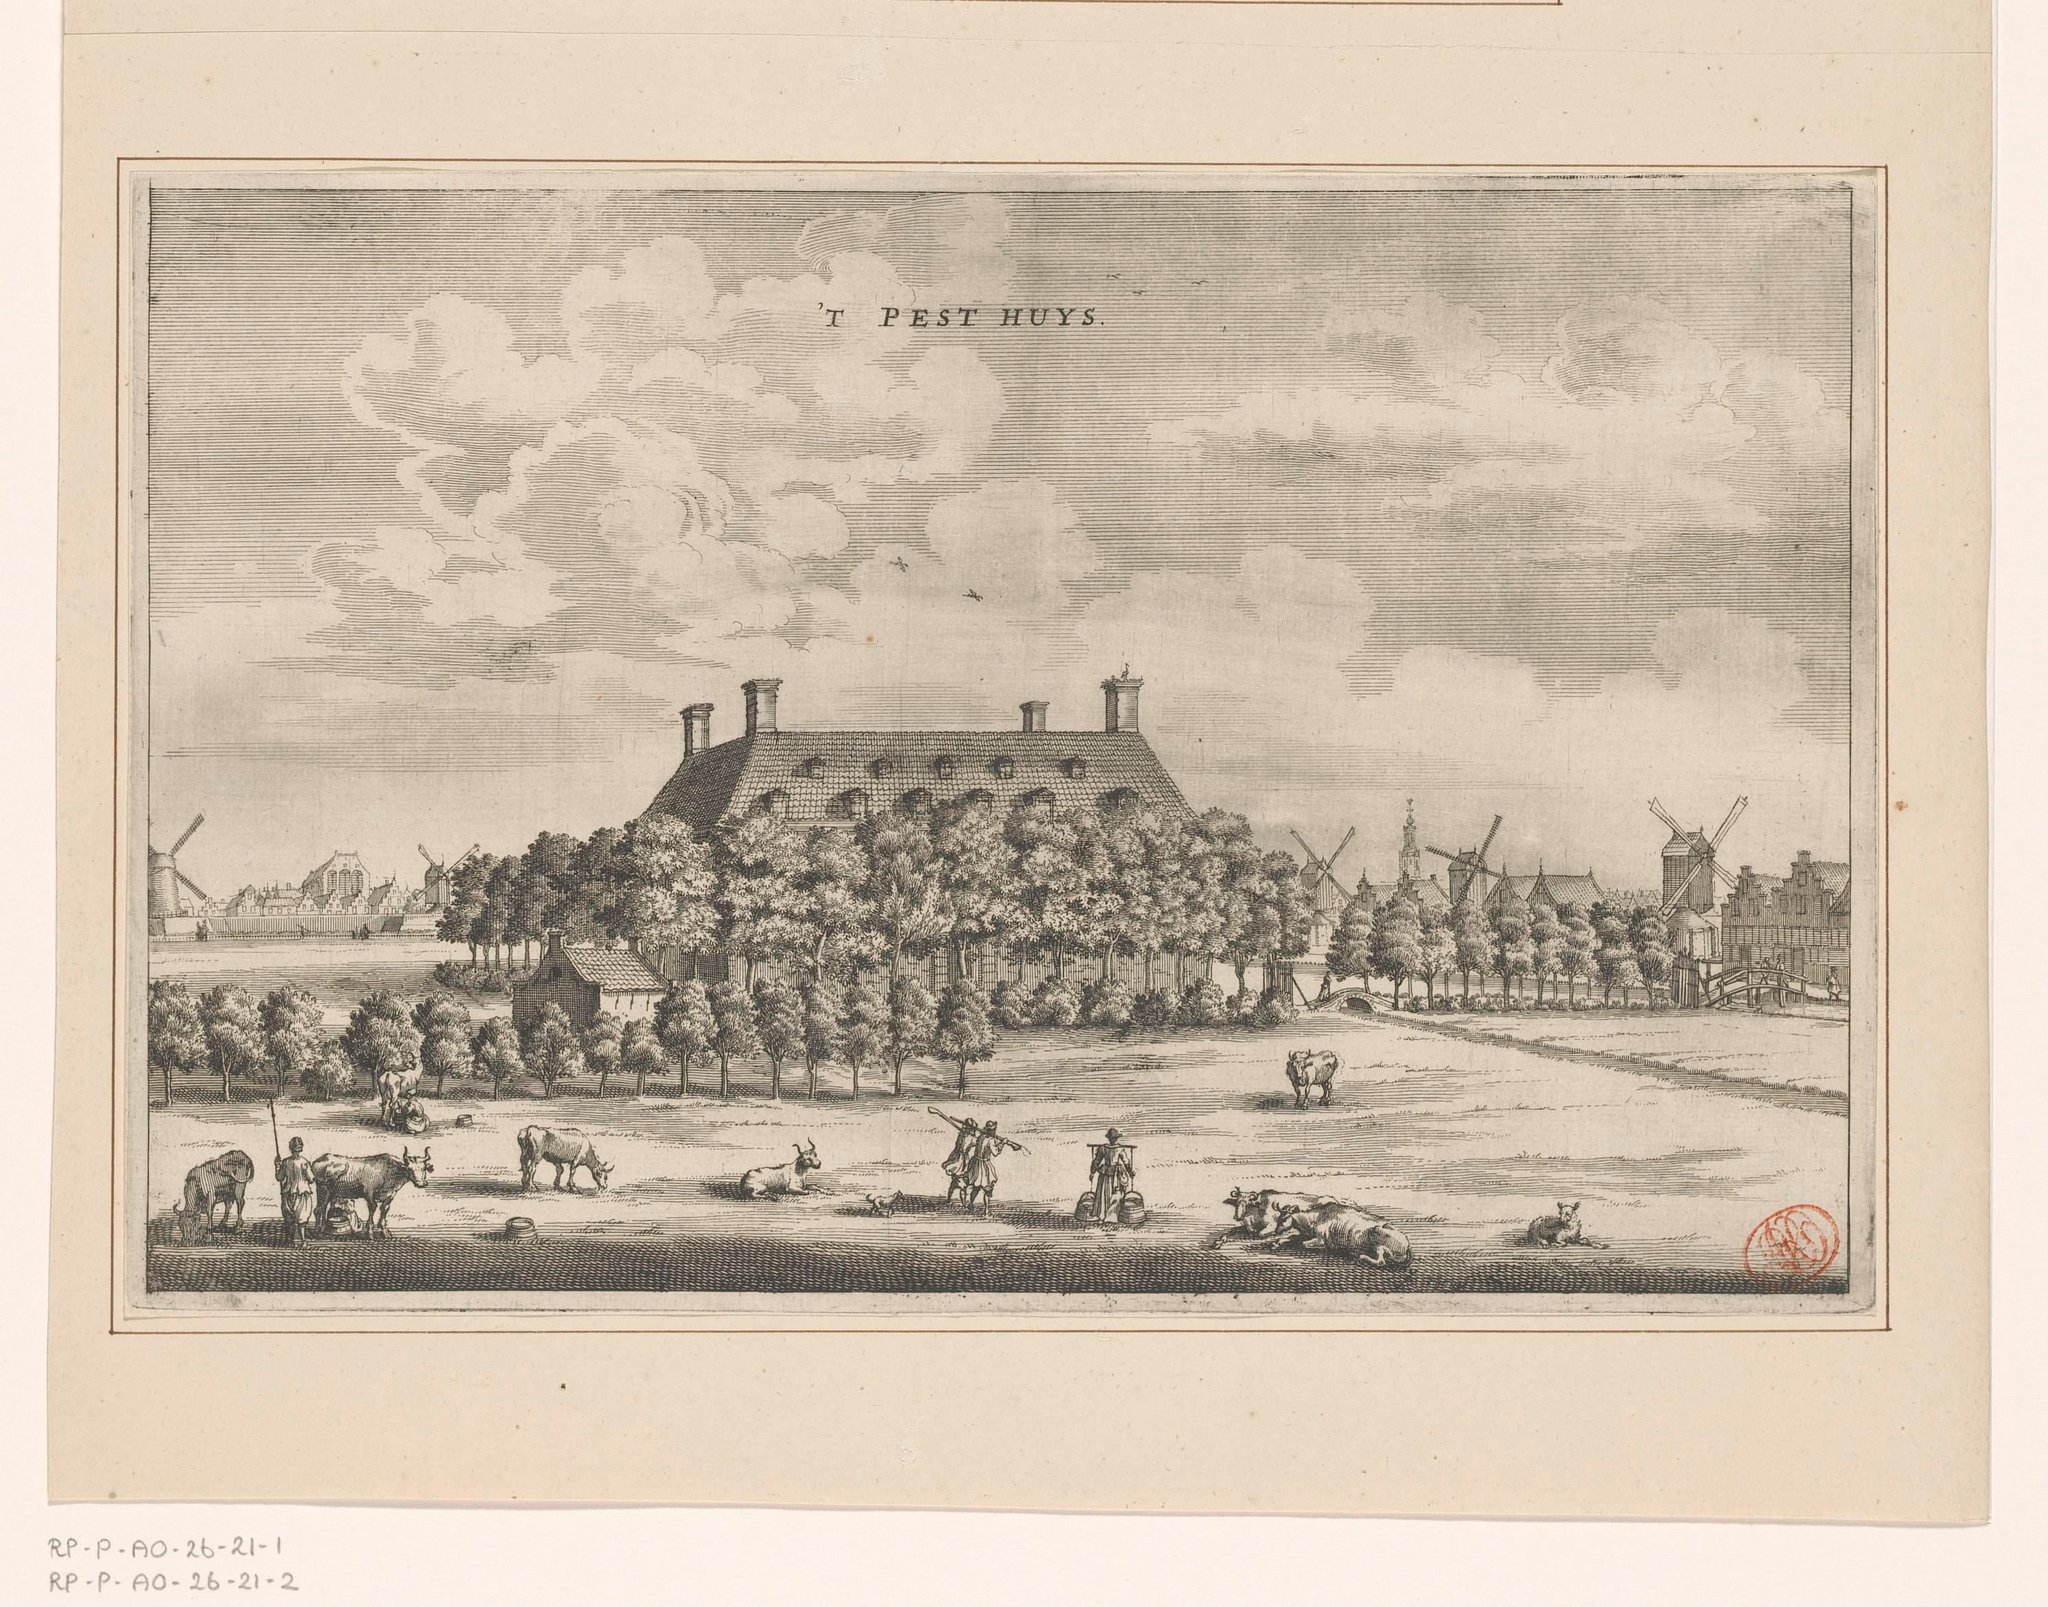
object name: print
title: Gezicht op het Pesthuis (Buitengasthuis) bij Amsterdam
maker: jacob van meurs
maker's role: draughtsman, print maker, publisher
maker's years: 1619-1680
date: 1663-1664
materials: paper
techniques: engraving, etching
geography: amsterdam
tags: public welfare, hospital, prospect of city, town panorama, silhouette of city, amsterdam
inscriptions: collector's mark: Lugt 195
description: Huidige staat van prent ook gebruikt in: Dapper, Olfert. Historische beschryving der stadt Amsterdam: waer in de voornaemste geschiedenissen (na een kort verhael van gansch Hollant en d'omleggende dorpen (…). Amsterdam: Jacob van Meurs, 1663.* En in: Zesen, Philipp von. Beschreibung der Stadt Amsterdam: darinnen von derselben ersten Ursprunge bis auf gegenwärtigen Zustand (…). Amsterdam: Joachim Nosche, 1664. * In sommige exemplaren van deze uitgave komt de huidige staat van de prent voor. In andere exemplaren is een latere staat ingebonden, waarop boven de Nederlandse een Franse titel is toegevoegd.